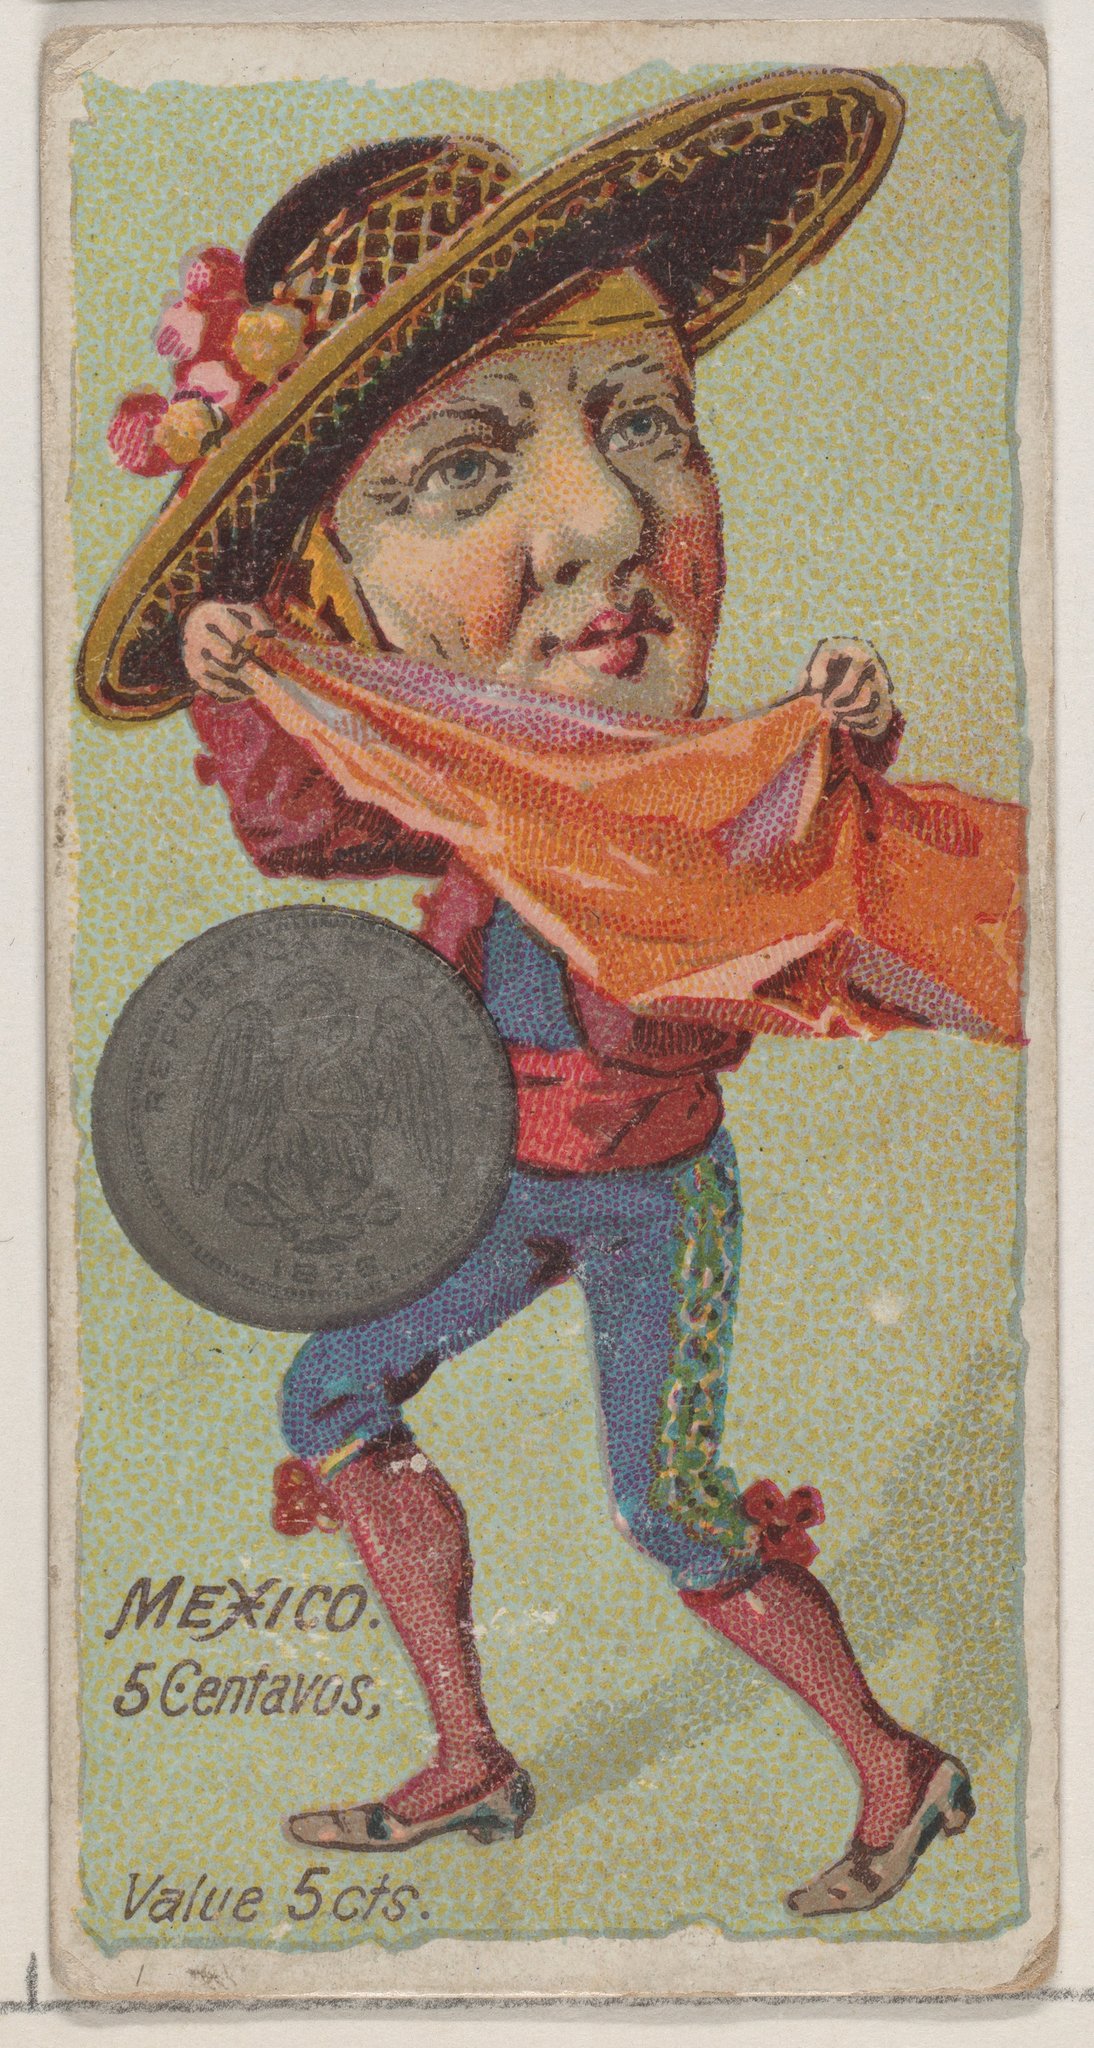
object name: print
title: Caricatured Mexican, 5 Centavos, from the series Coins of All Nations (N72, variation 2) for Duke brand cigarettes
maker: w. duke, sons & co.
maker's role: publisher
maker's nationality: american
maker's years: 1870-1920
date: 1889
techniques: color lithograph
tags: men,coins